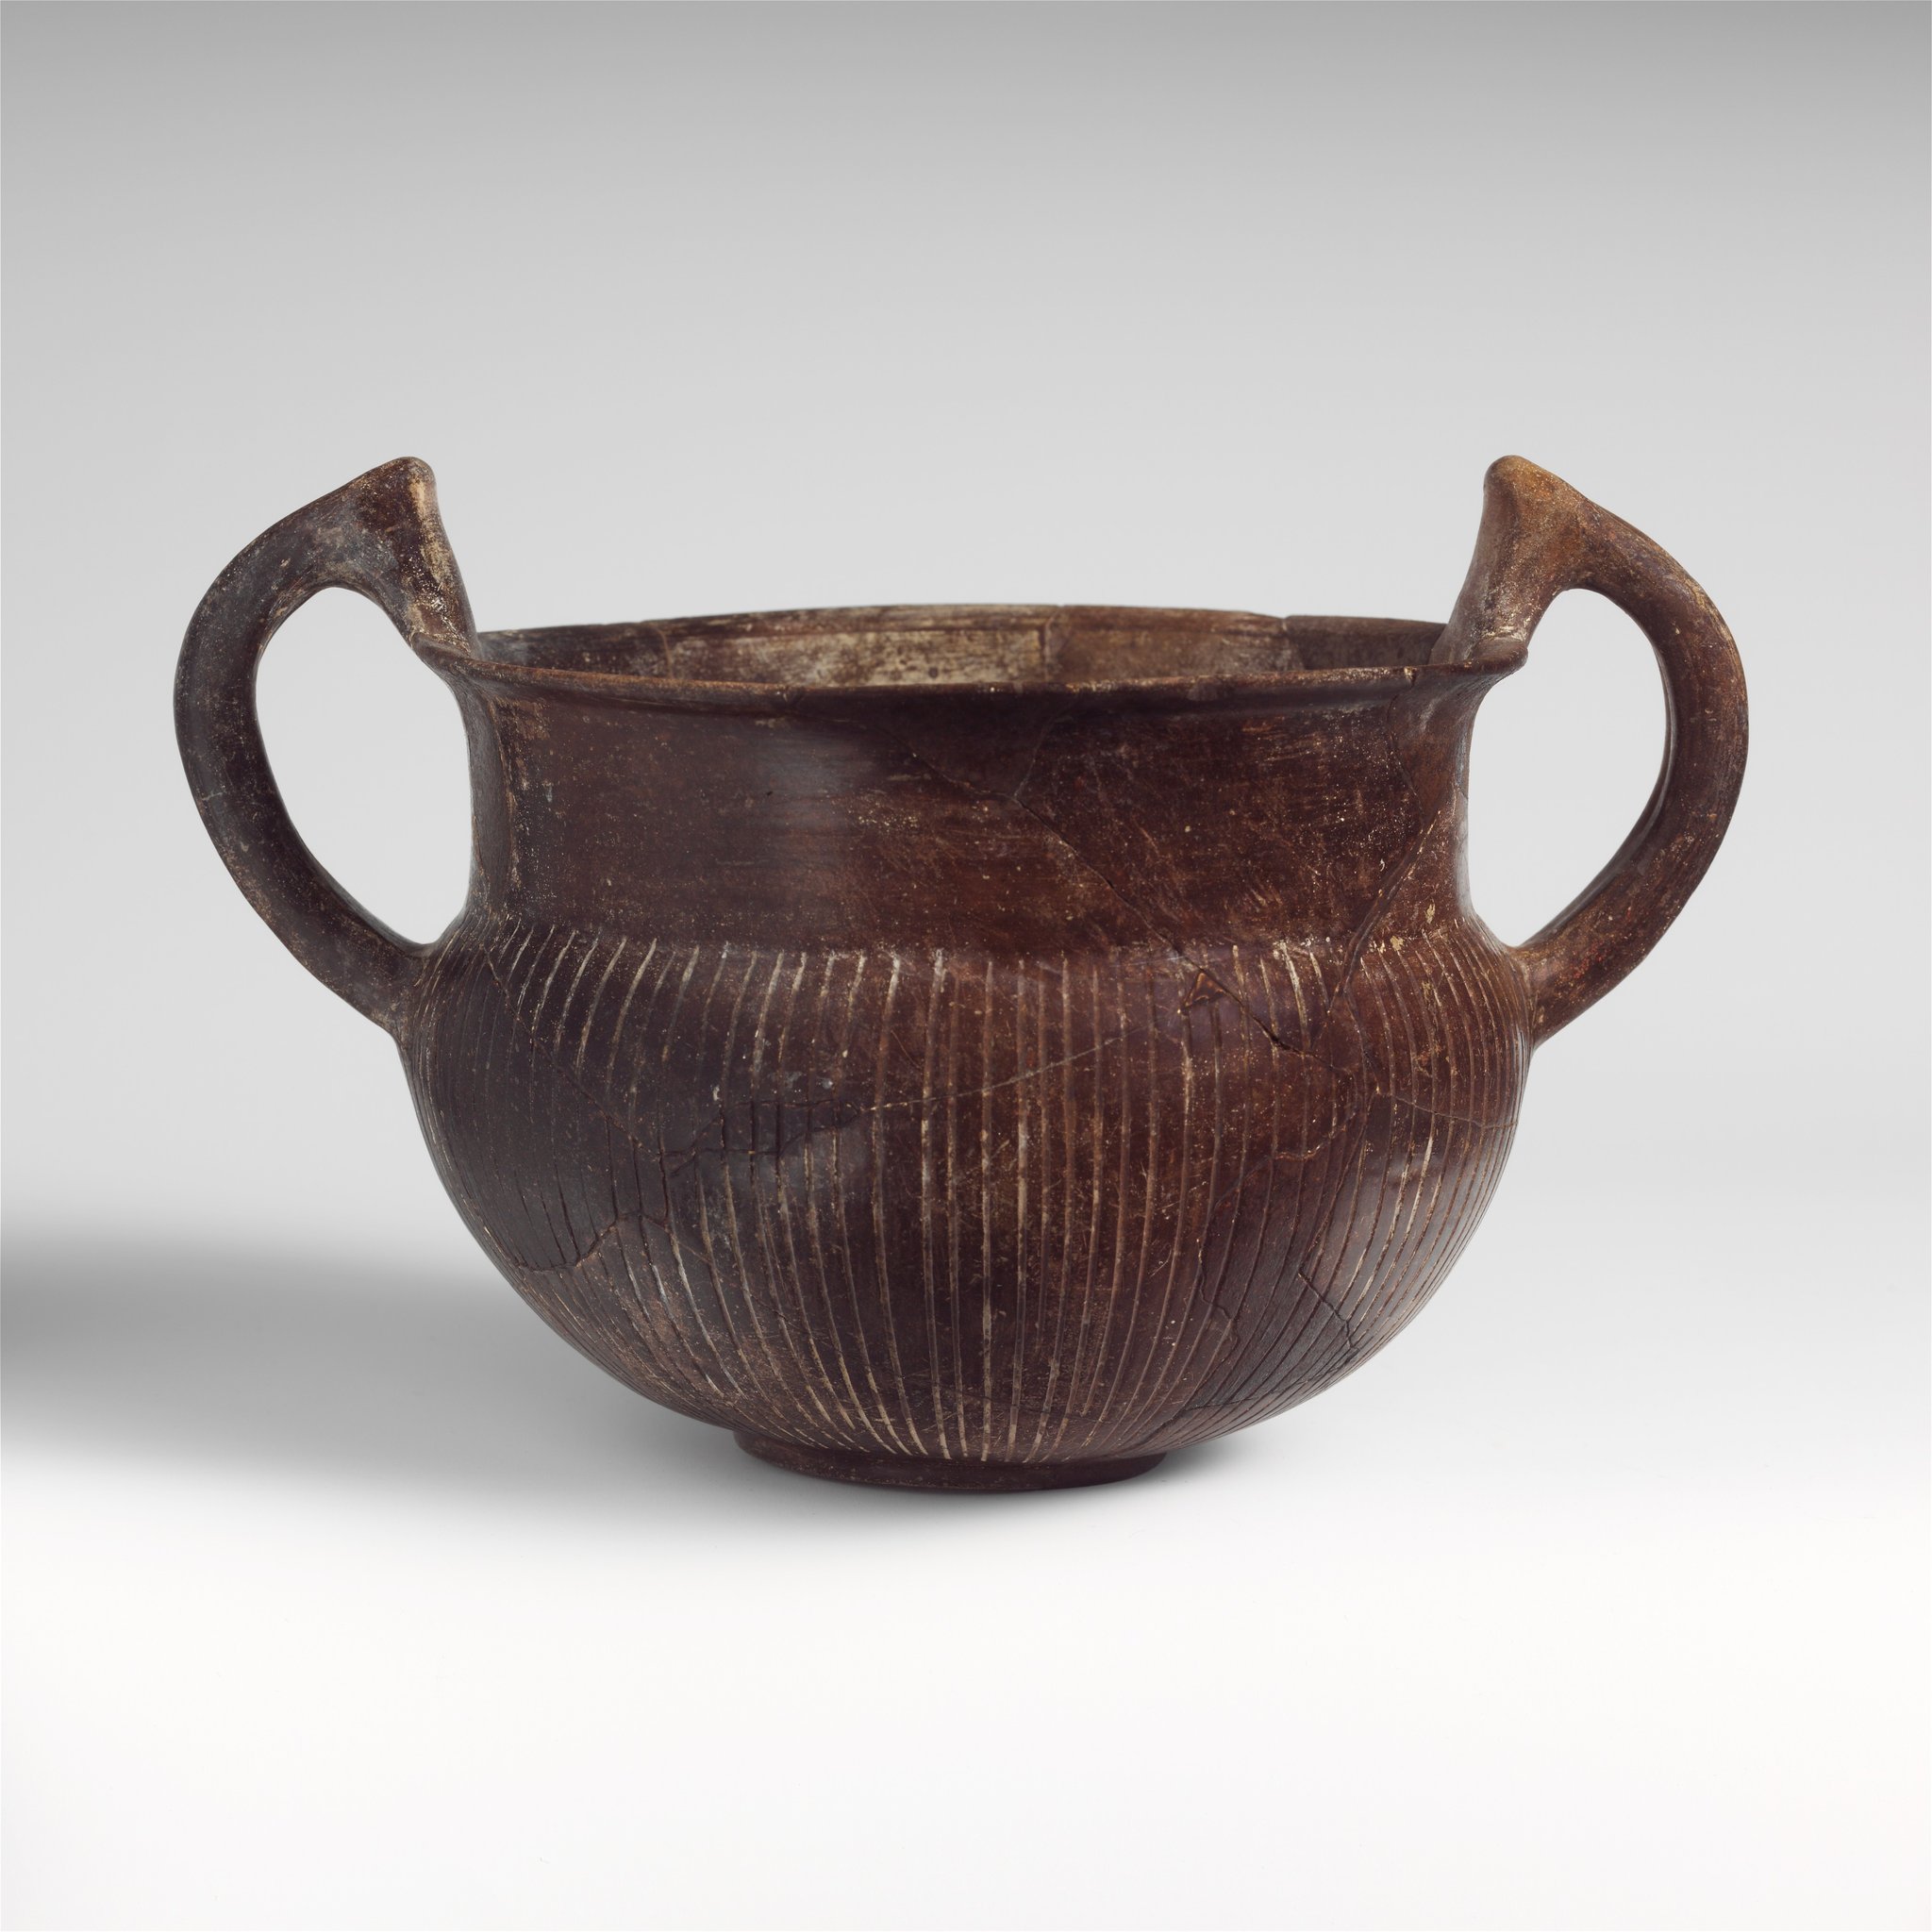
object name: bowl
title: Terracotta two-handled bowl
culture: italic, villanovan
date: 700-601 BCE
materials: terracotta